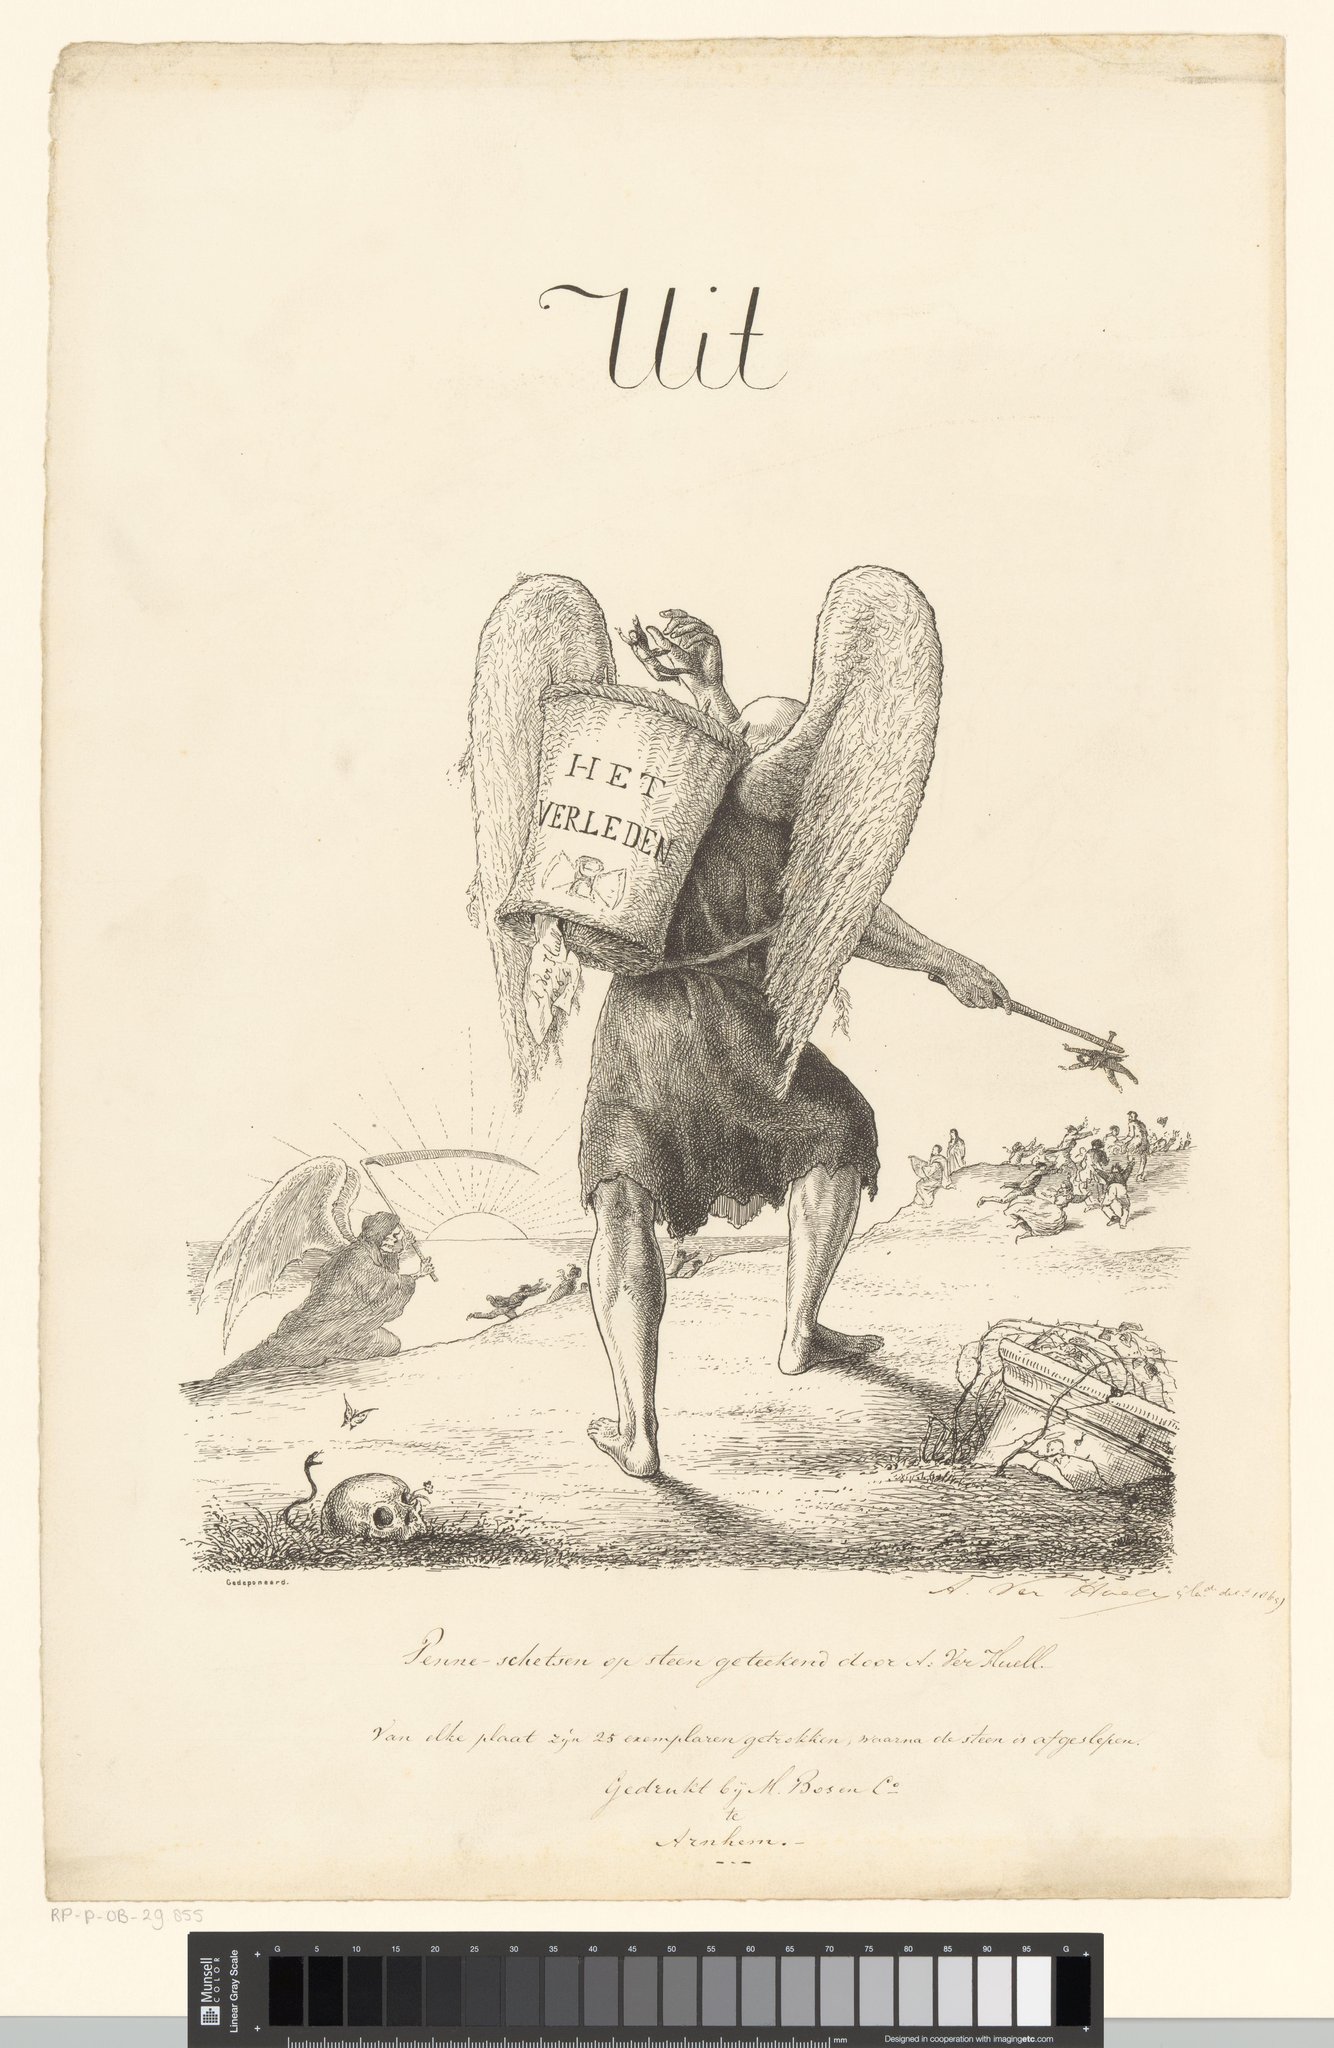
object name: titelprent, frontispice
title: Vader Tijd pakt vluchtende mensen op en stopt ze in een mand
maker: alexander ver huell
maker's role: draughtsman, print maker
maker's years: 1822-1897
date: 1864-1866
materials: paper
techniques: lithograph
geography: arnhem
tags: father time, man with wings and scythe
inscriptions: : ‘Gedeponeerd.’, collector's mark: Lugt 2228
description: Vader Tijd pakt vluchtende mensen op en stopt ze in de mand op zijn rug. Links jaagt de Dood met een zeis op de mensen.